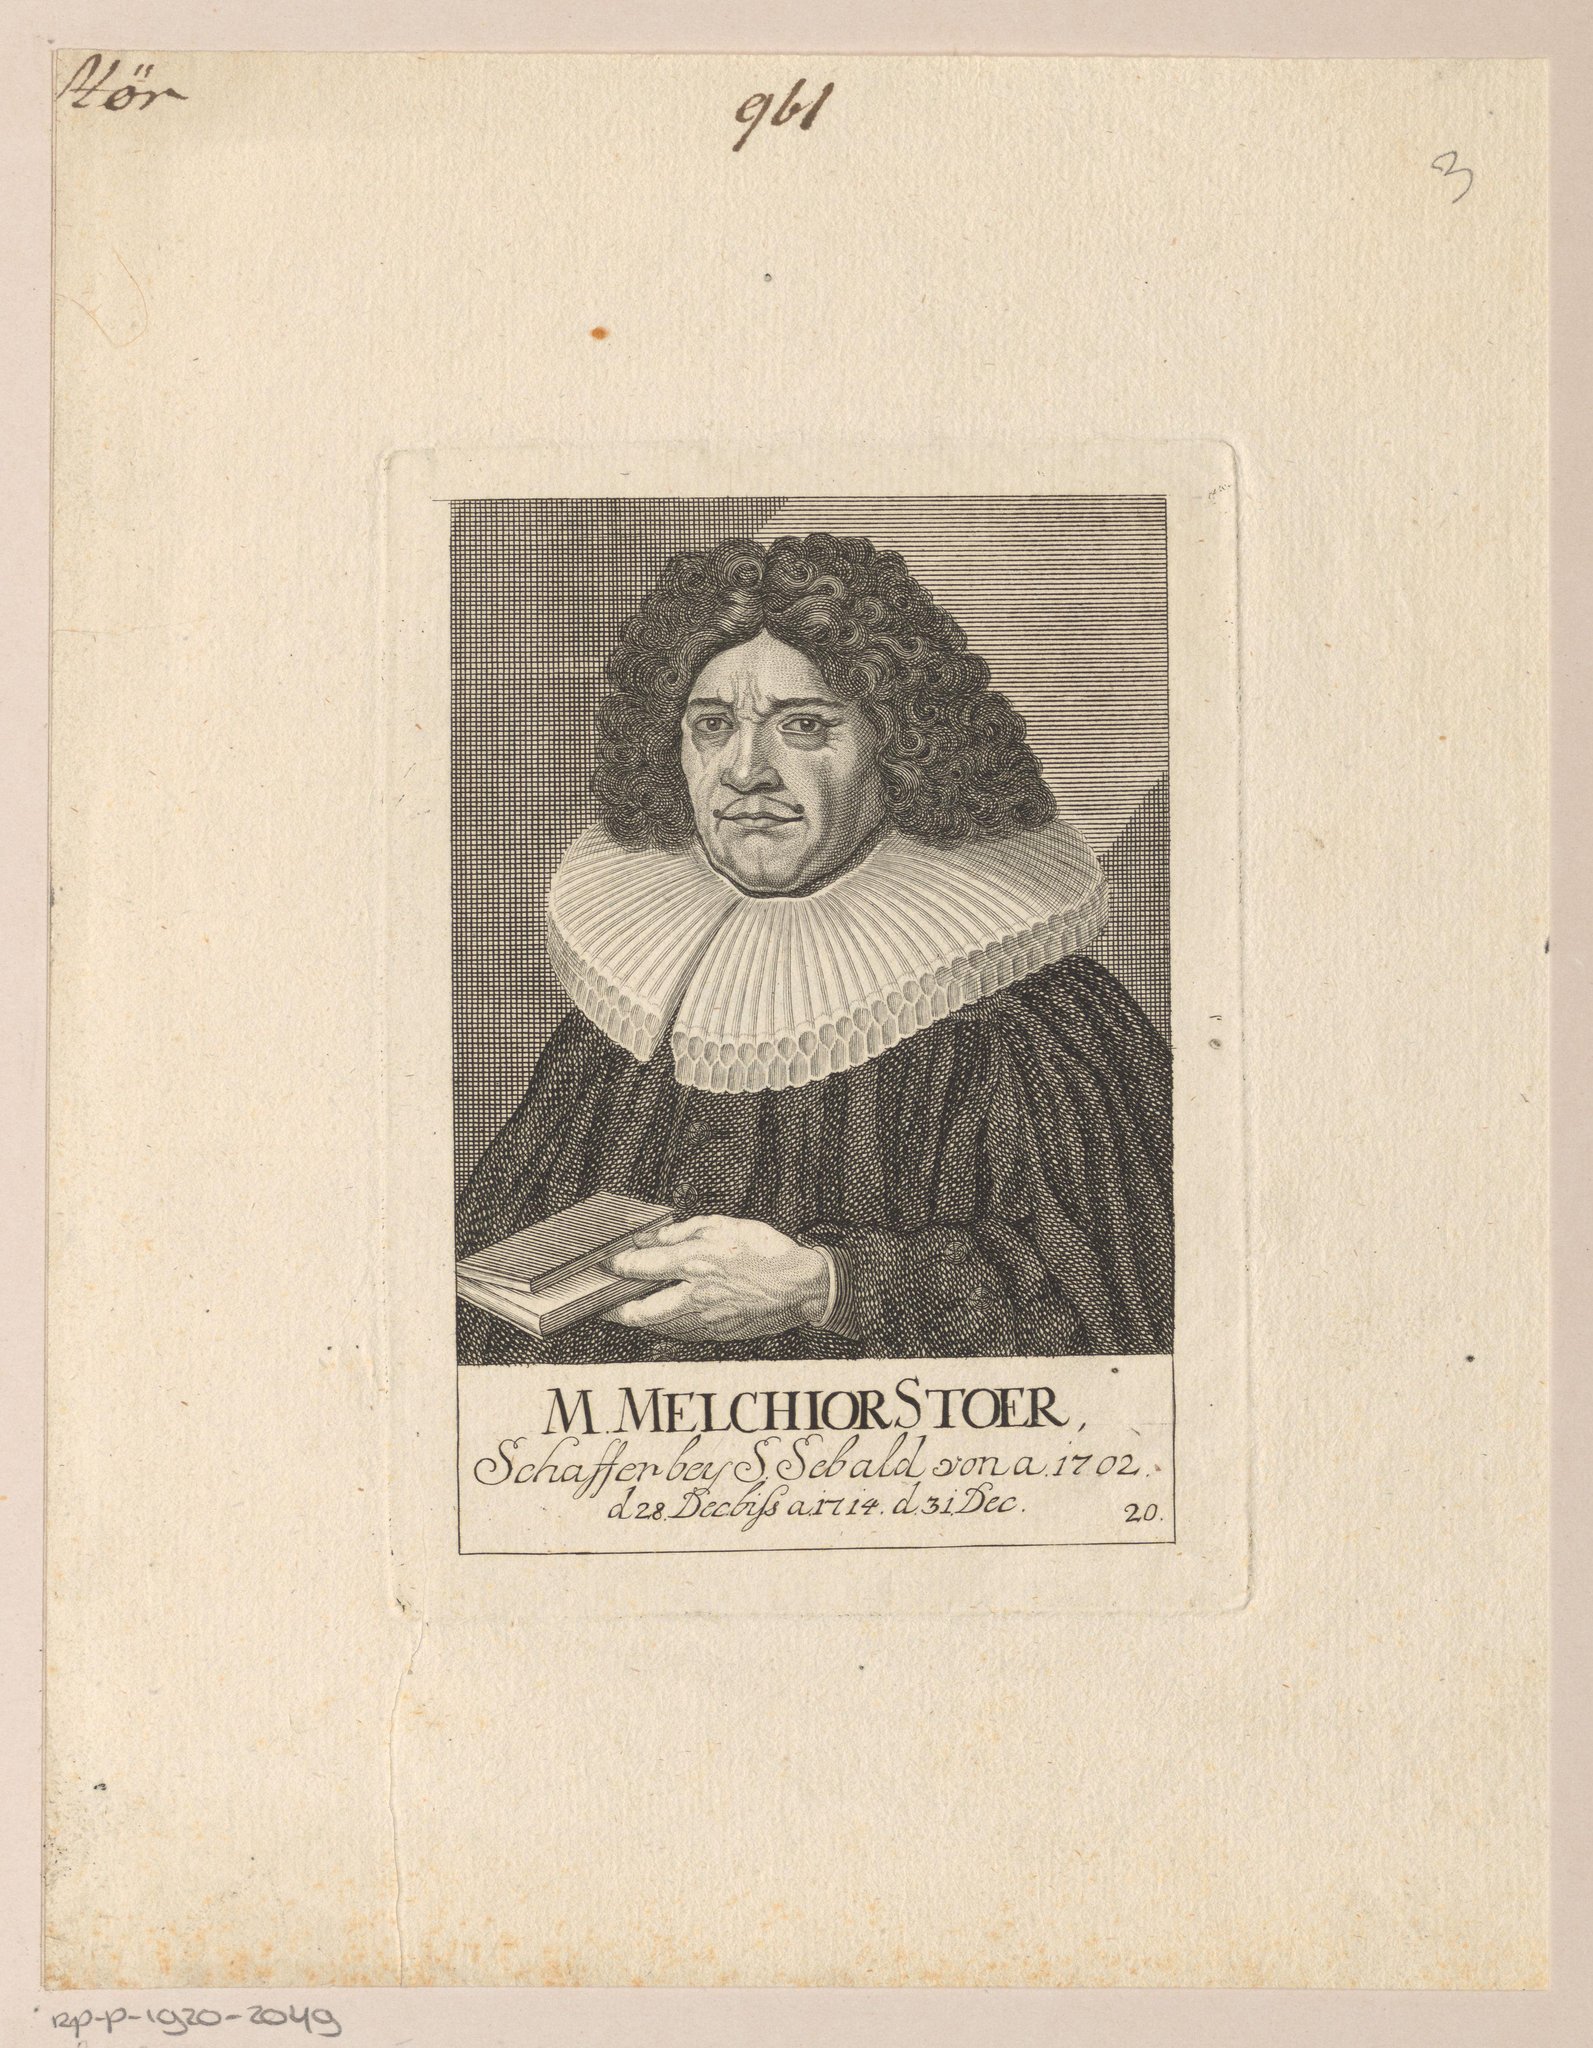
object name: print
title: Portret van Melchior Stör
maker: christoph melchior roth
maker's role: print maker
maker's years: 1720-1798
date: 1756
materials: paper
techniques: engraving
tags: theologian, historical persons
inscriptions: collector's mark: Lugt 2228, inscription: ‘Stör / 961’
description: Prent uit: Würfel, Andreas. Diptycha ecclesiae Sebaldianae (...). Neurenberg: Christoph Melchior Roth, 1756.